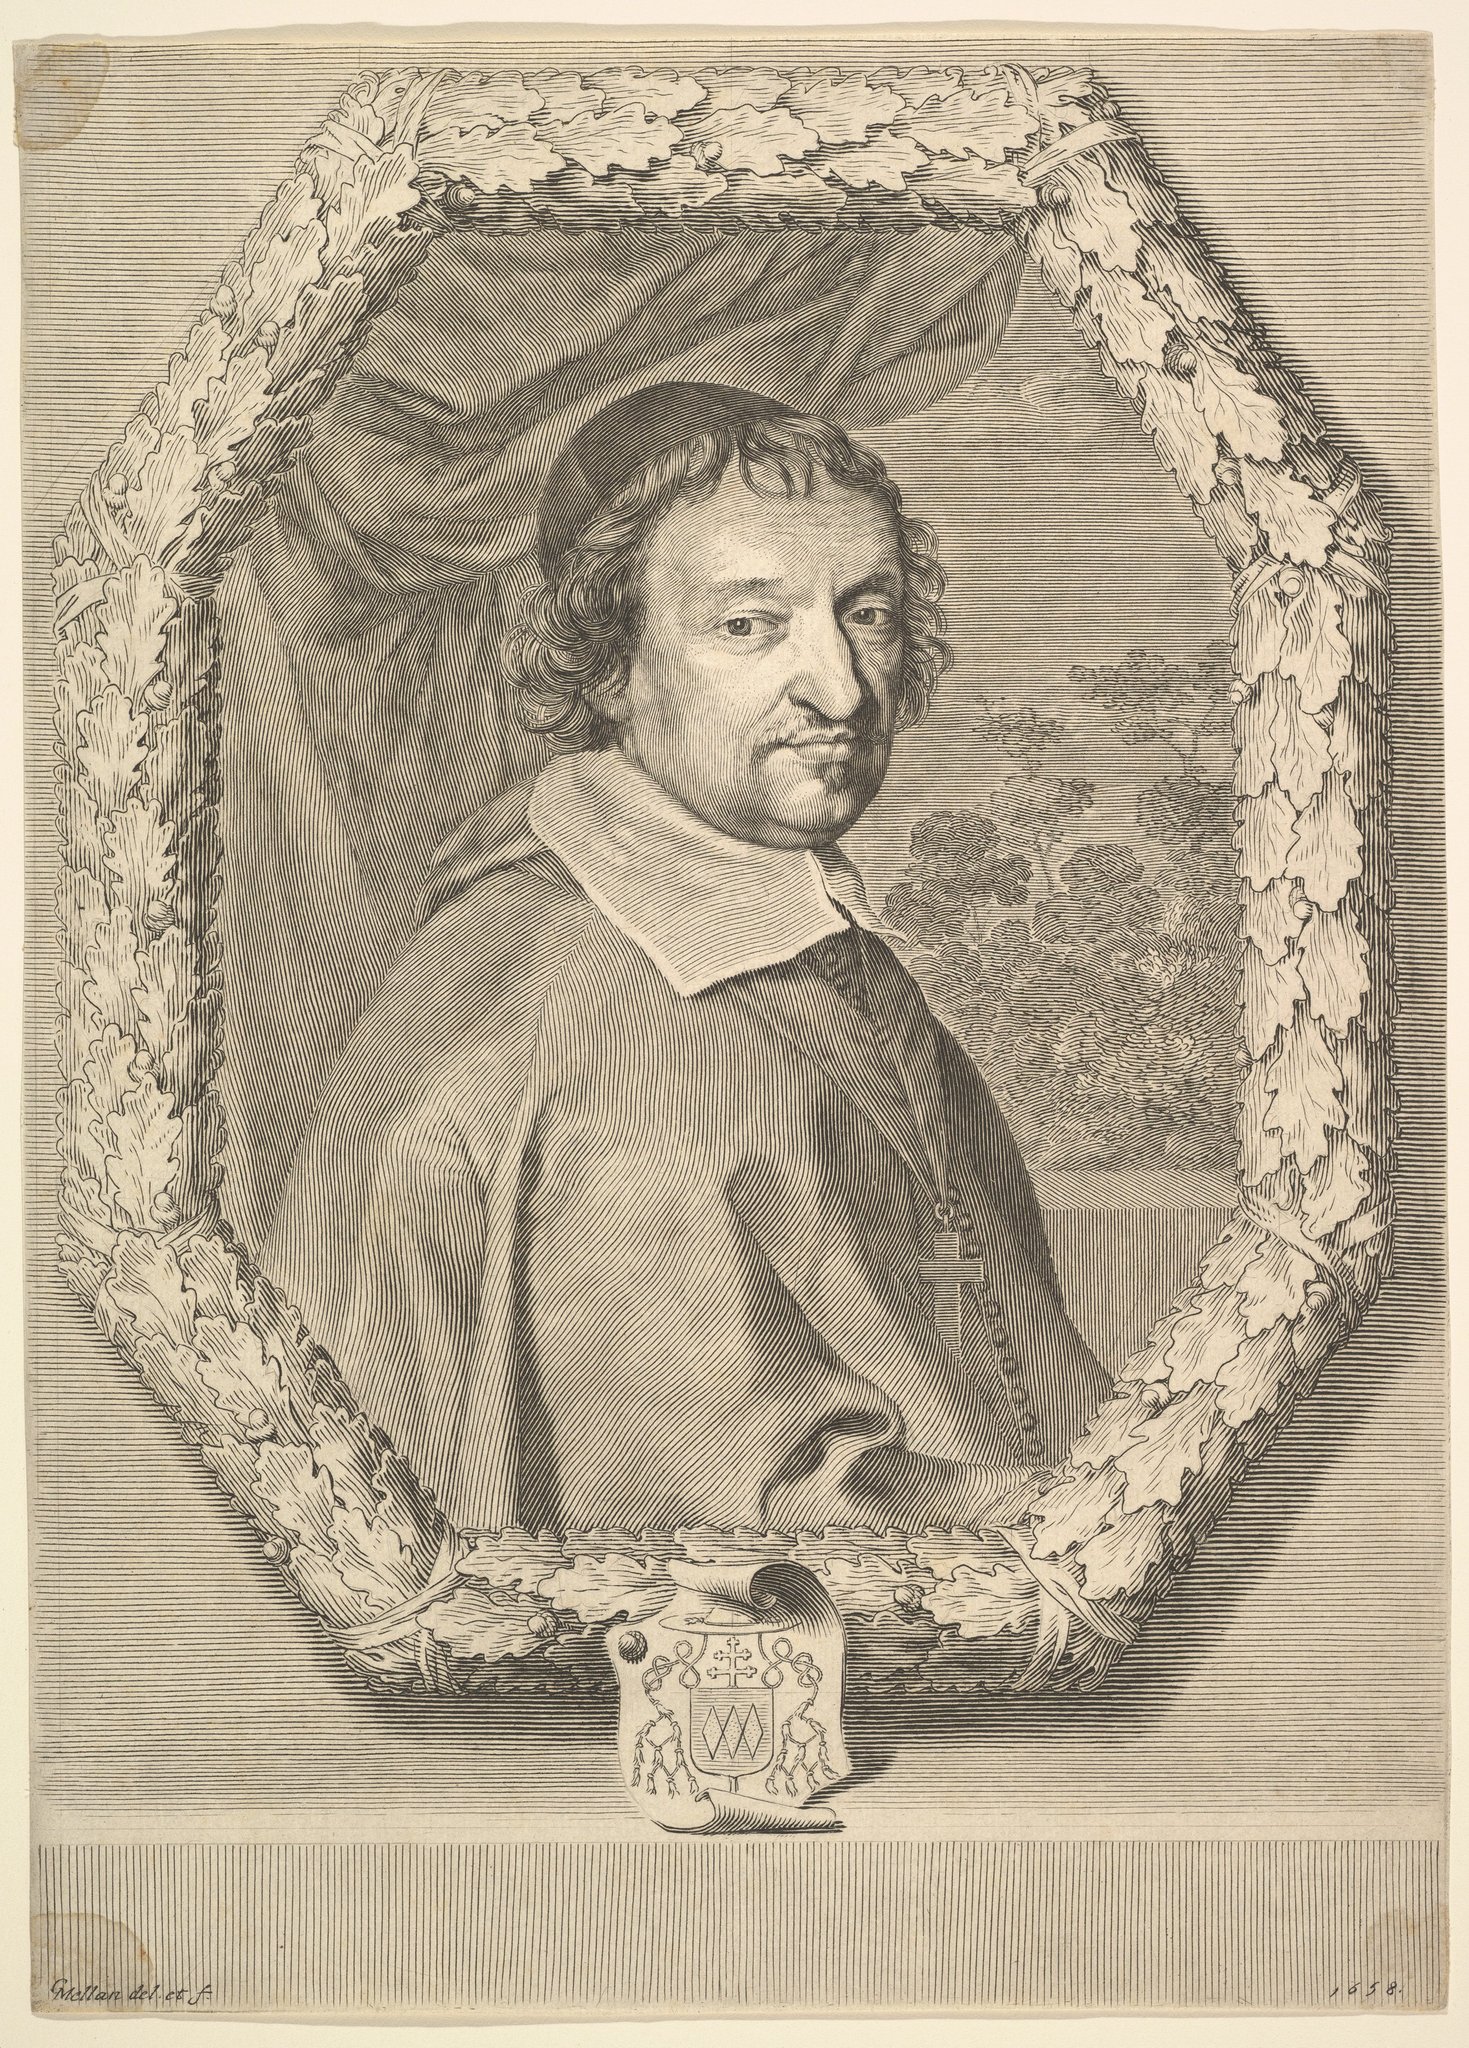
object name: print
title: Victor le Bouthillier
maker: claude mellan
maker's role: artist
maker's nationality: french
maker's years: 1598-1688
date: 1658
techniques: engraving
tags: men,portraits